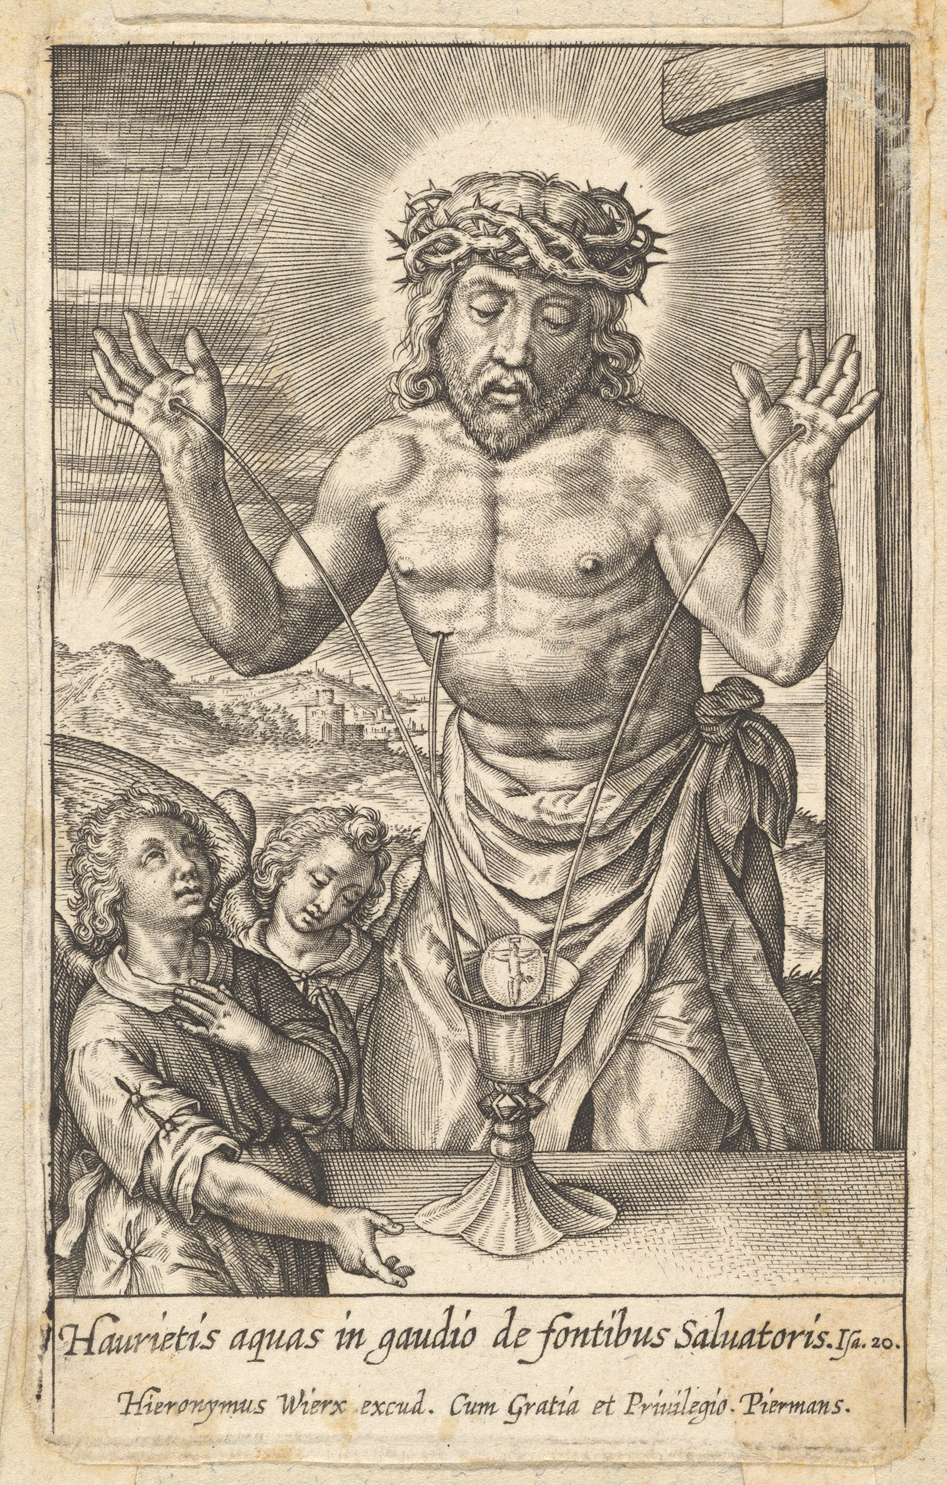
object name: print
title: The Blood of the Redeemer Venerated by Two Angels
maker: hieronymus wierix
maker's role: artist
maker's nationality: netherlandish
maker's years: 1553-1619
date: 1619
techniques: engraving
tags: angels,christ